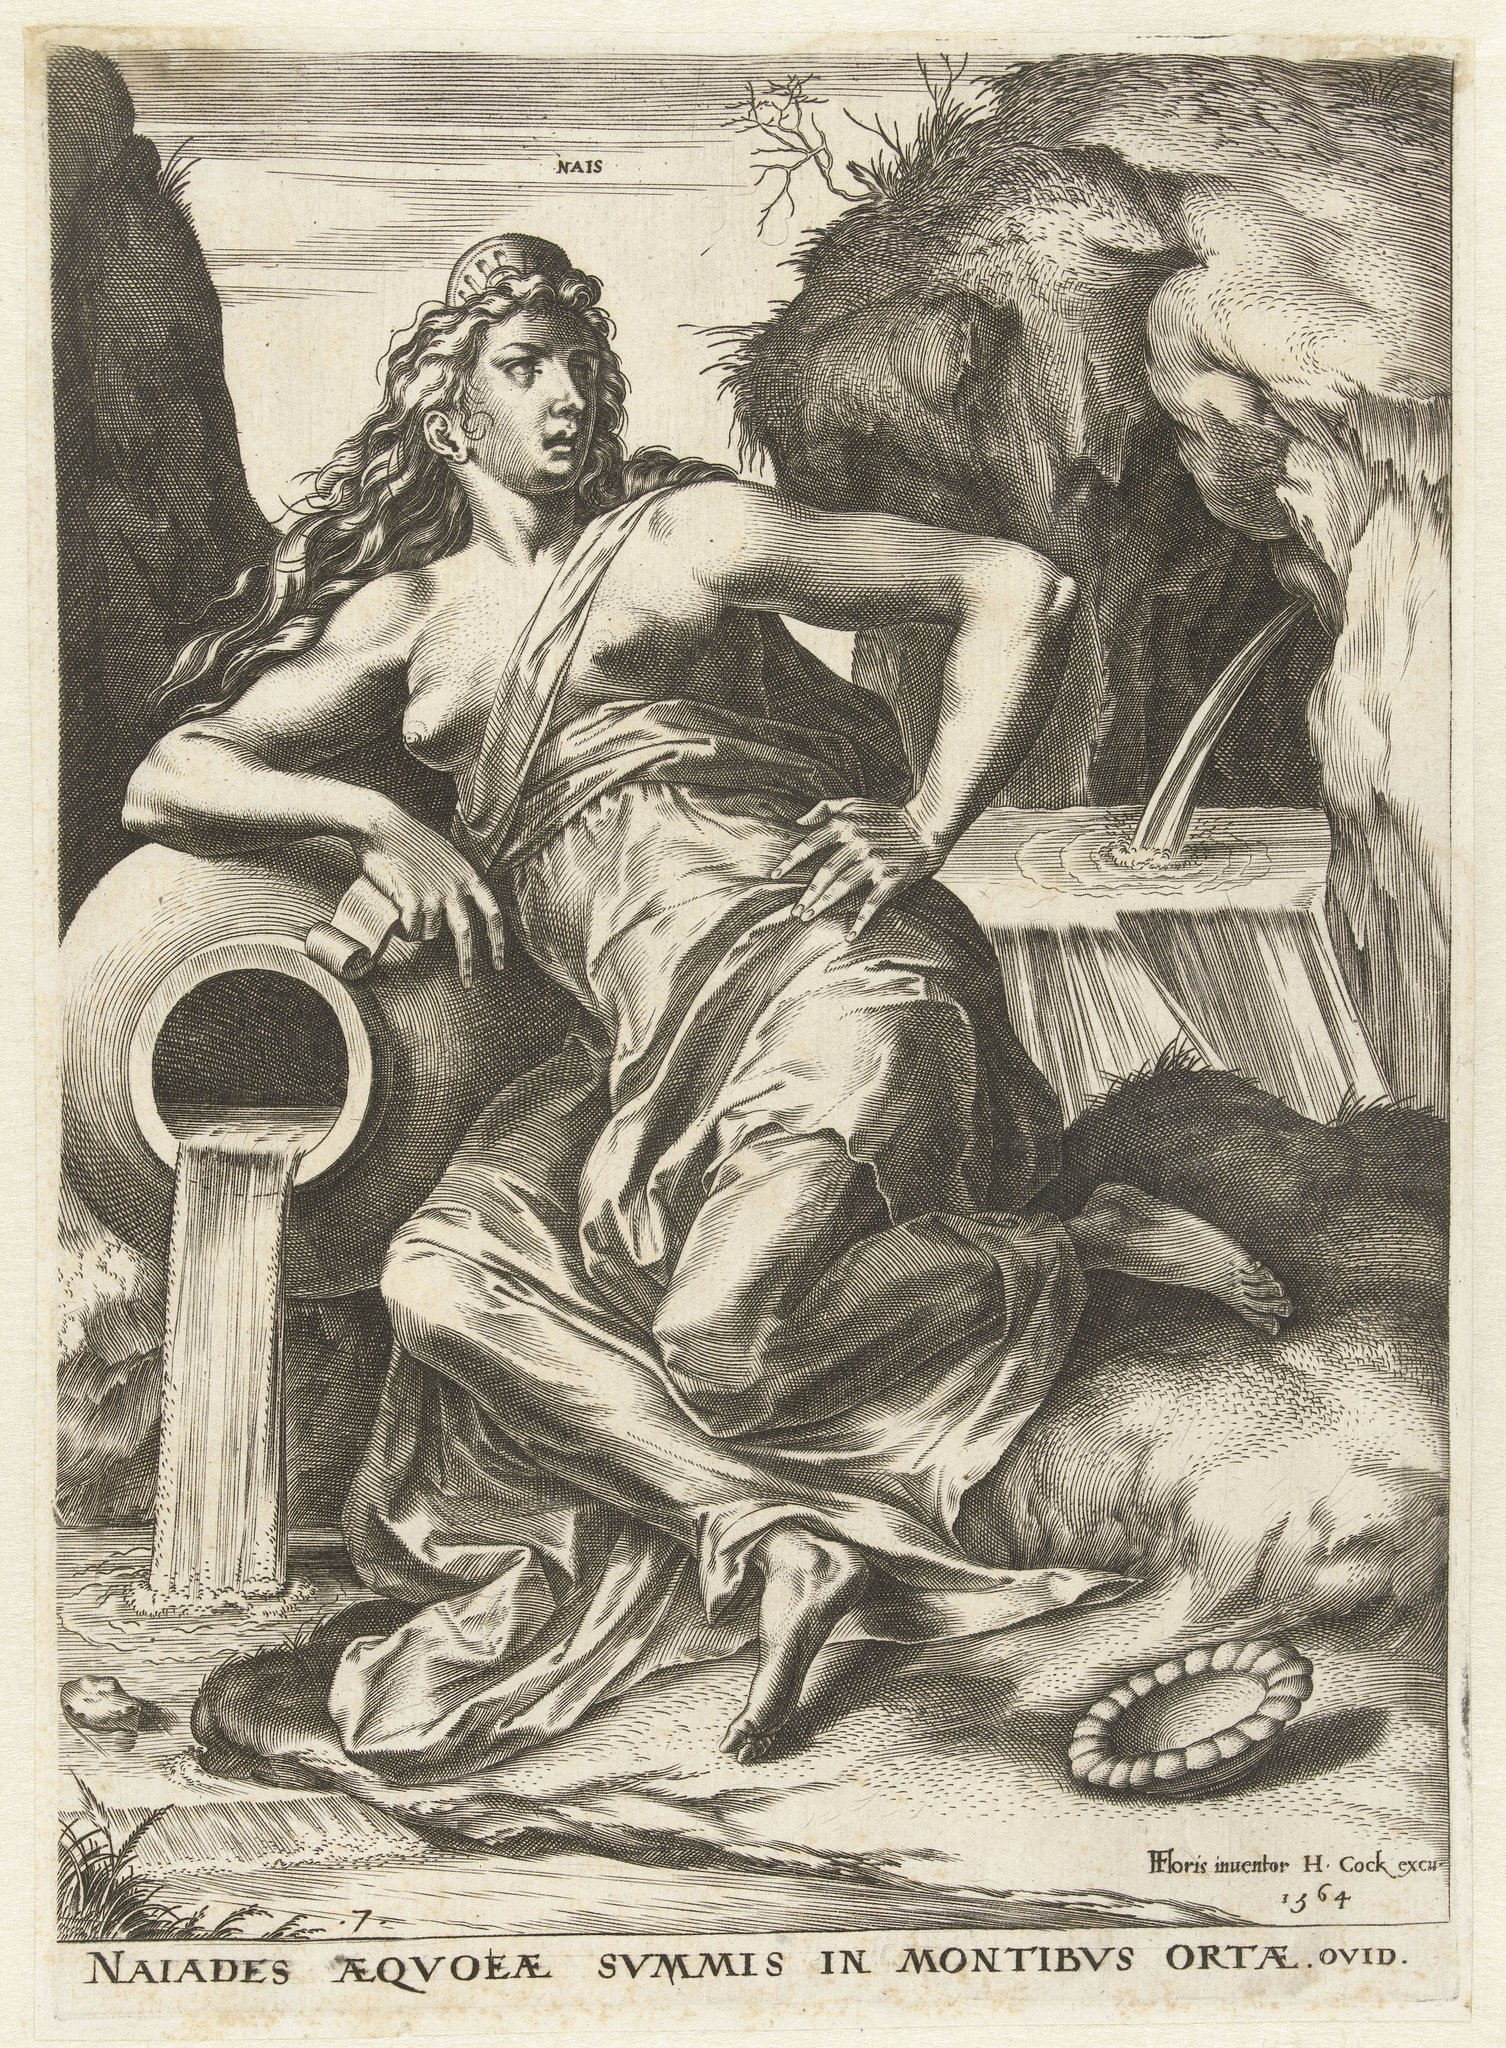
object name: print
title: Naiade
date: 1564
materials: paper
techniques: engraving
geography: antwerp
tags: naiads, river- and spring-nymphs; usually carrying an urn; 'naiadi, ninfe de' fiumi' (ripa)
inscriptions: collector's mark: Lugt 2542, collector's mark: Lugt 1379, collector's mark: Lugt 2228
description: Een riviernimf leunt tegen een kruik met water aan de bron van een rivier.